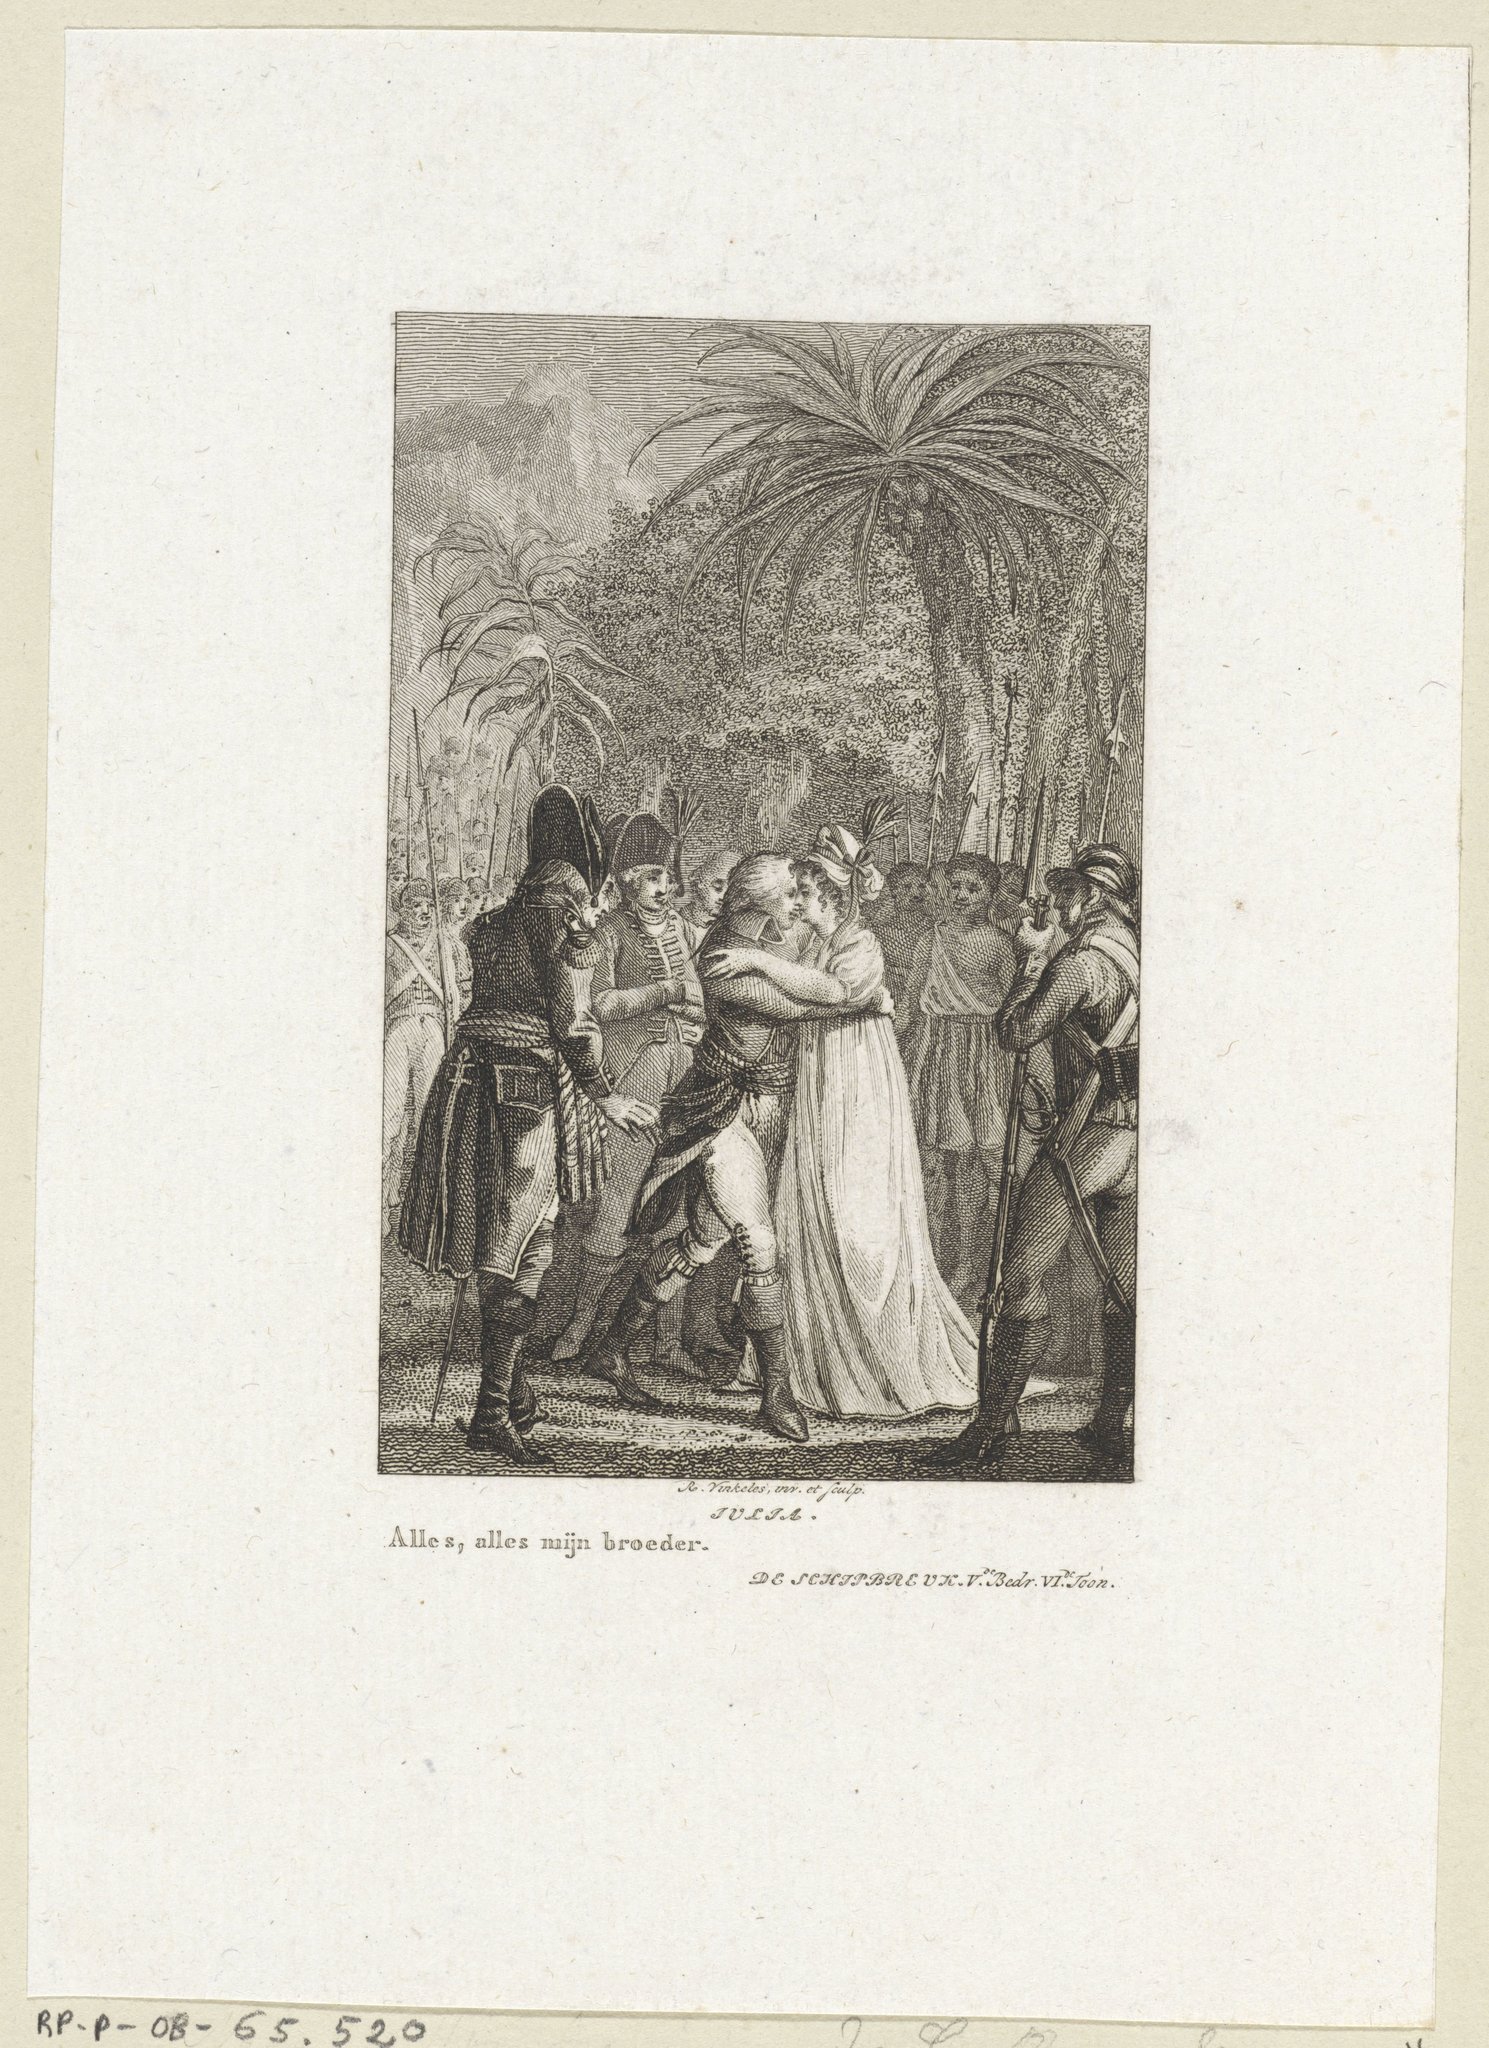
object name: print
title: Omringd door soldaten en Afrikanen omhelzen een man en vrouw elkaar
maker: reinier vinkeles (i)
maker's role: draughtsman, print maker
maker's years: 1741-1816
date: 1751-1816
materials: paper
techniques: engraving, etching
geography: amsterdam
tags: africans, embracing each other, kissing, the soldier; the soldier's life, trees: palm-tree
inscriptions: collector's mark: Lugt 240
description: Deze prent is mogelijk ook gebruikt als illustratie in: Brandes, J.C. De Schipbreuk.